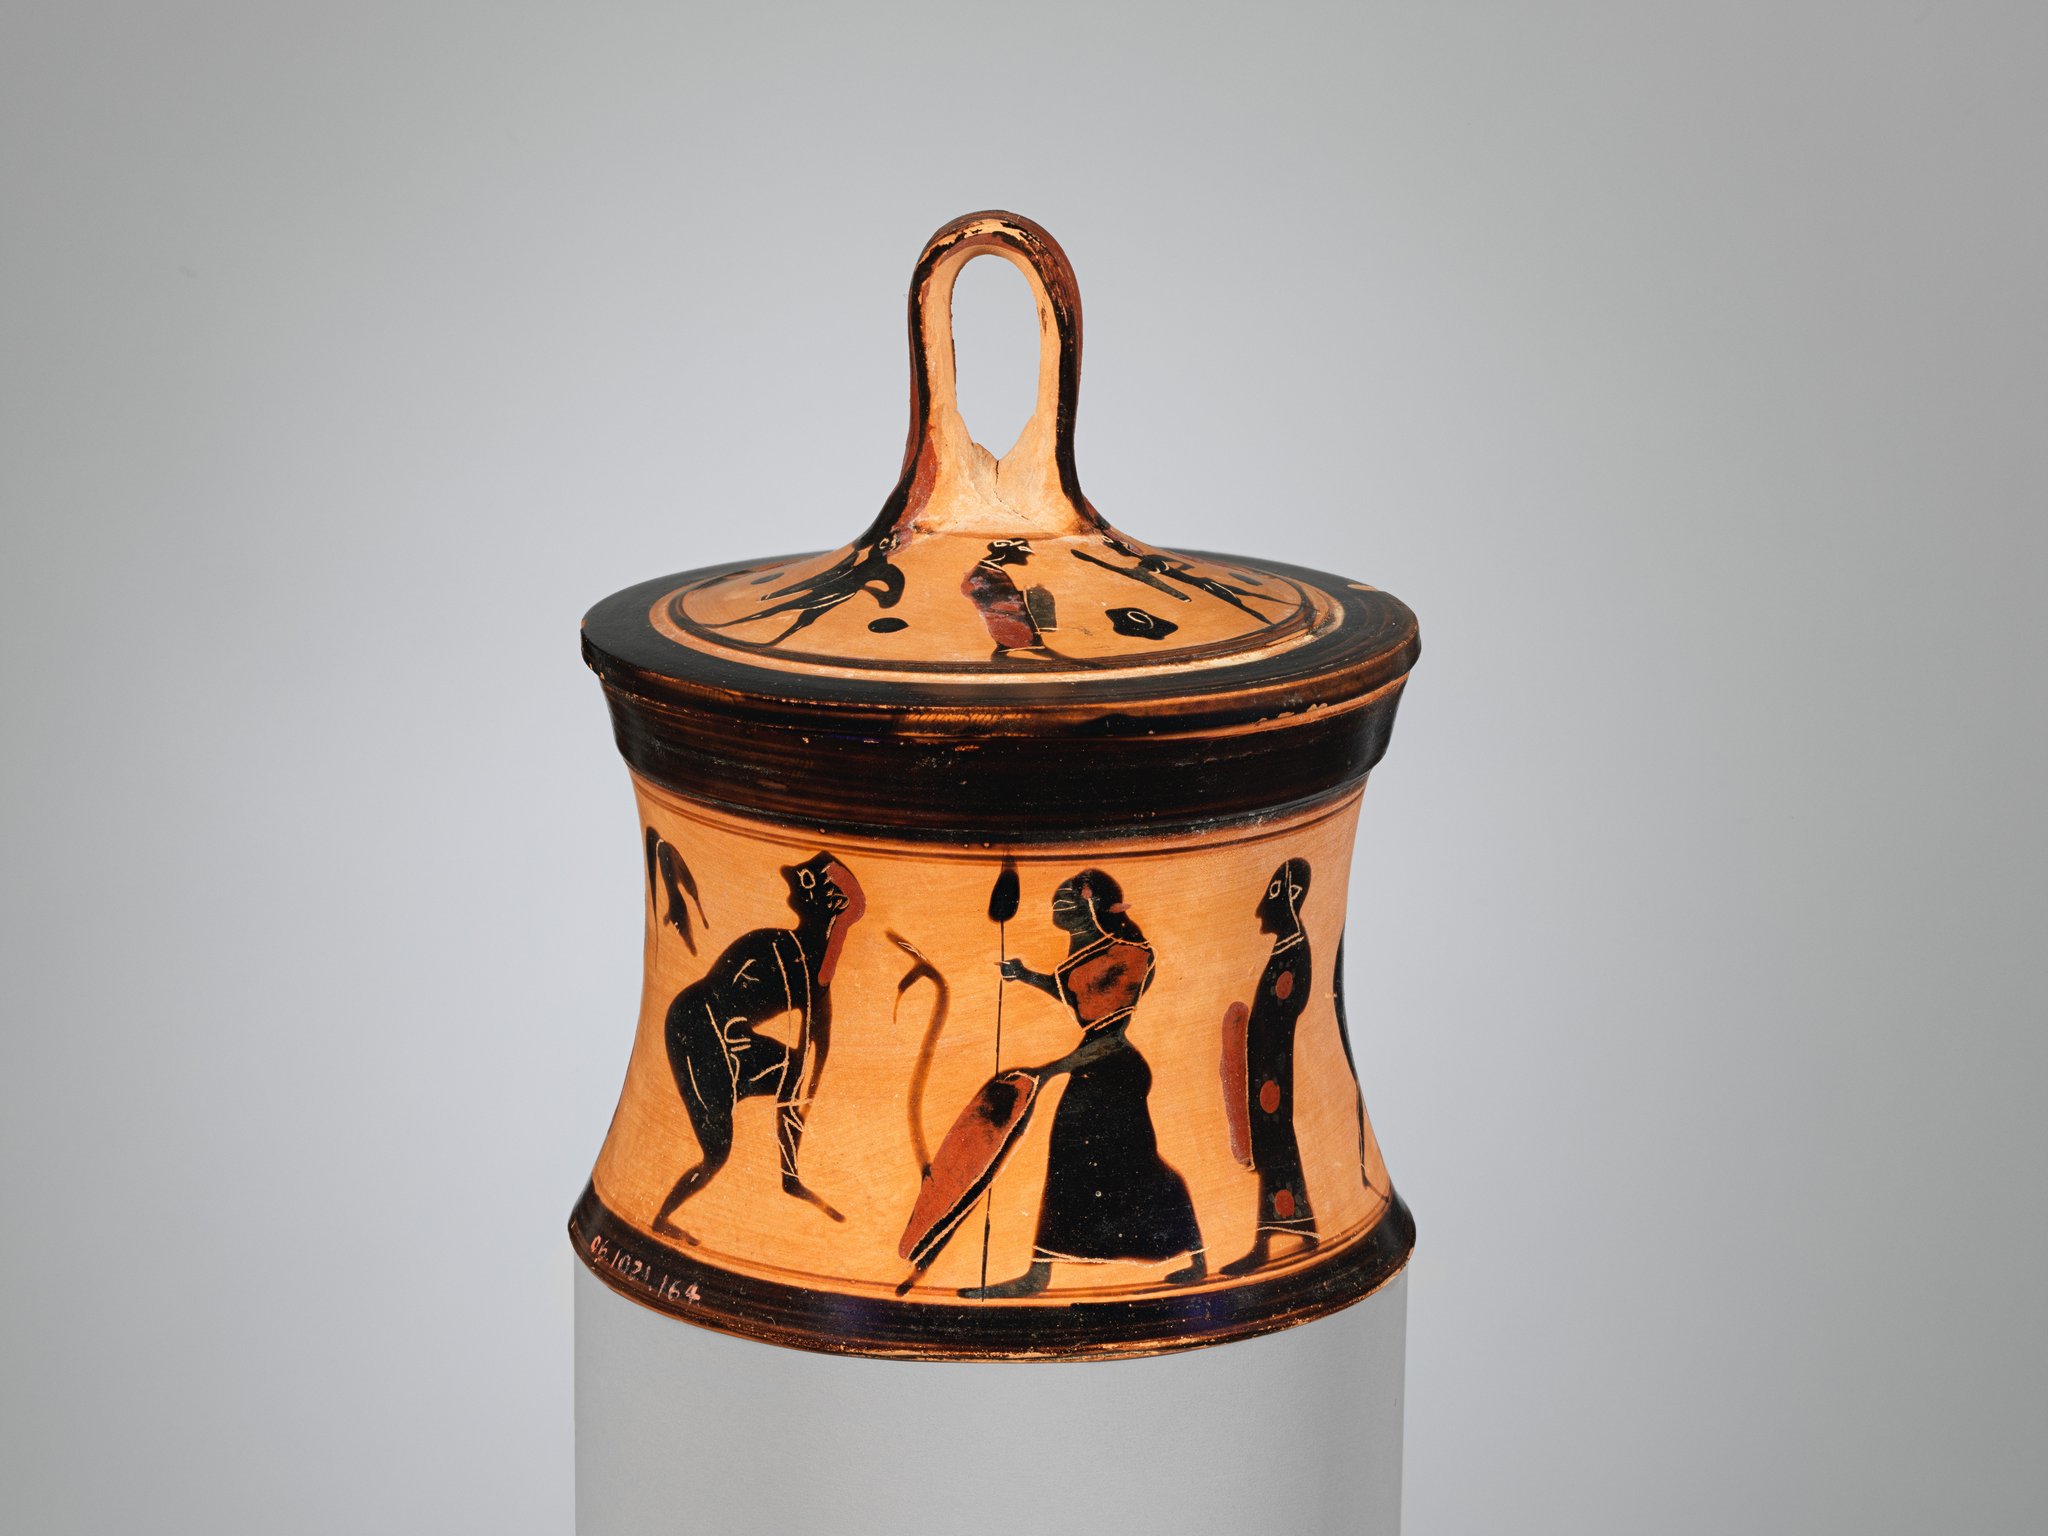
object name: pyxis with lid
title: Terracotta pyxis (box)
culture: greek, attic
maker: painter of munich 1842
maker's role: artist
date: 550 BCE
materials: terracotta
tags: armor,warriors